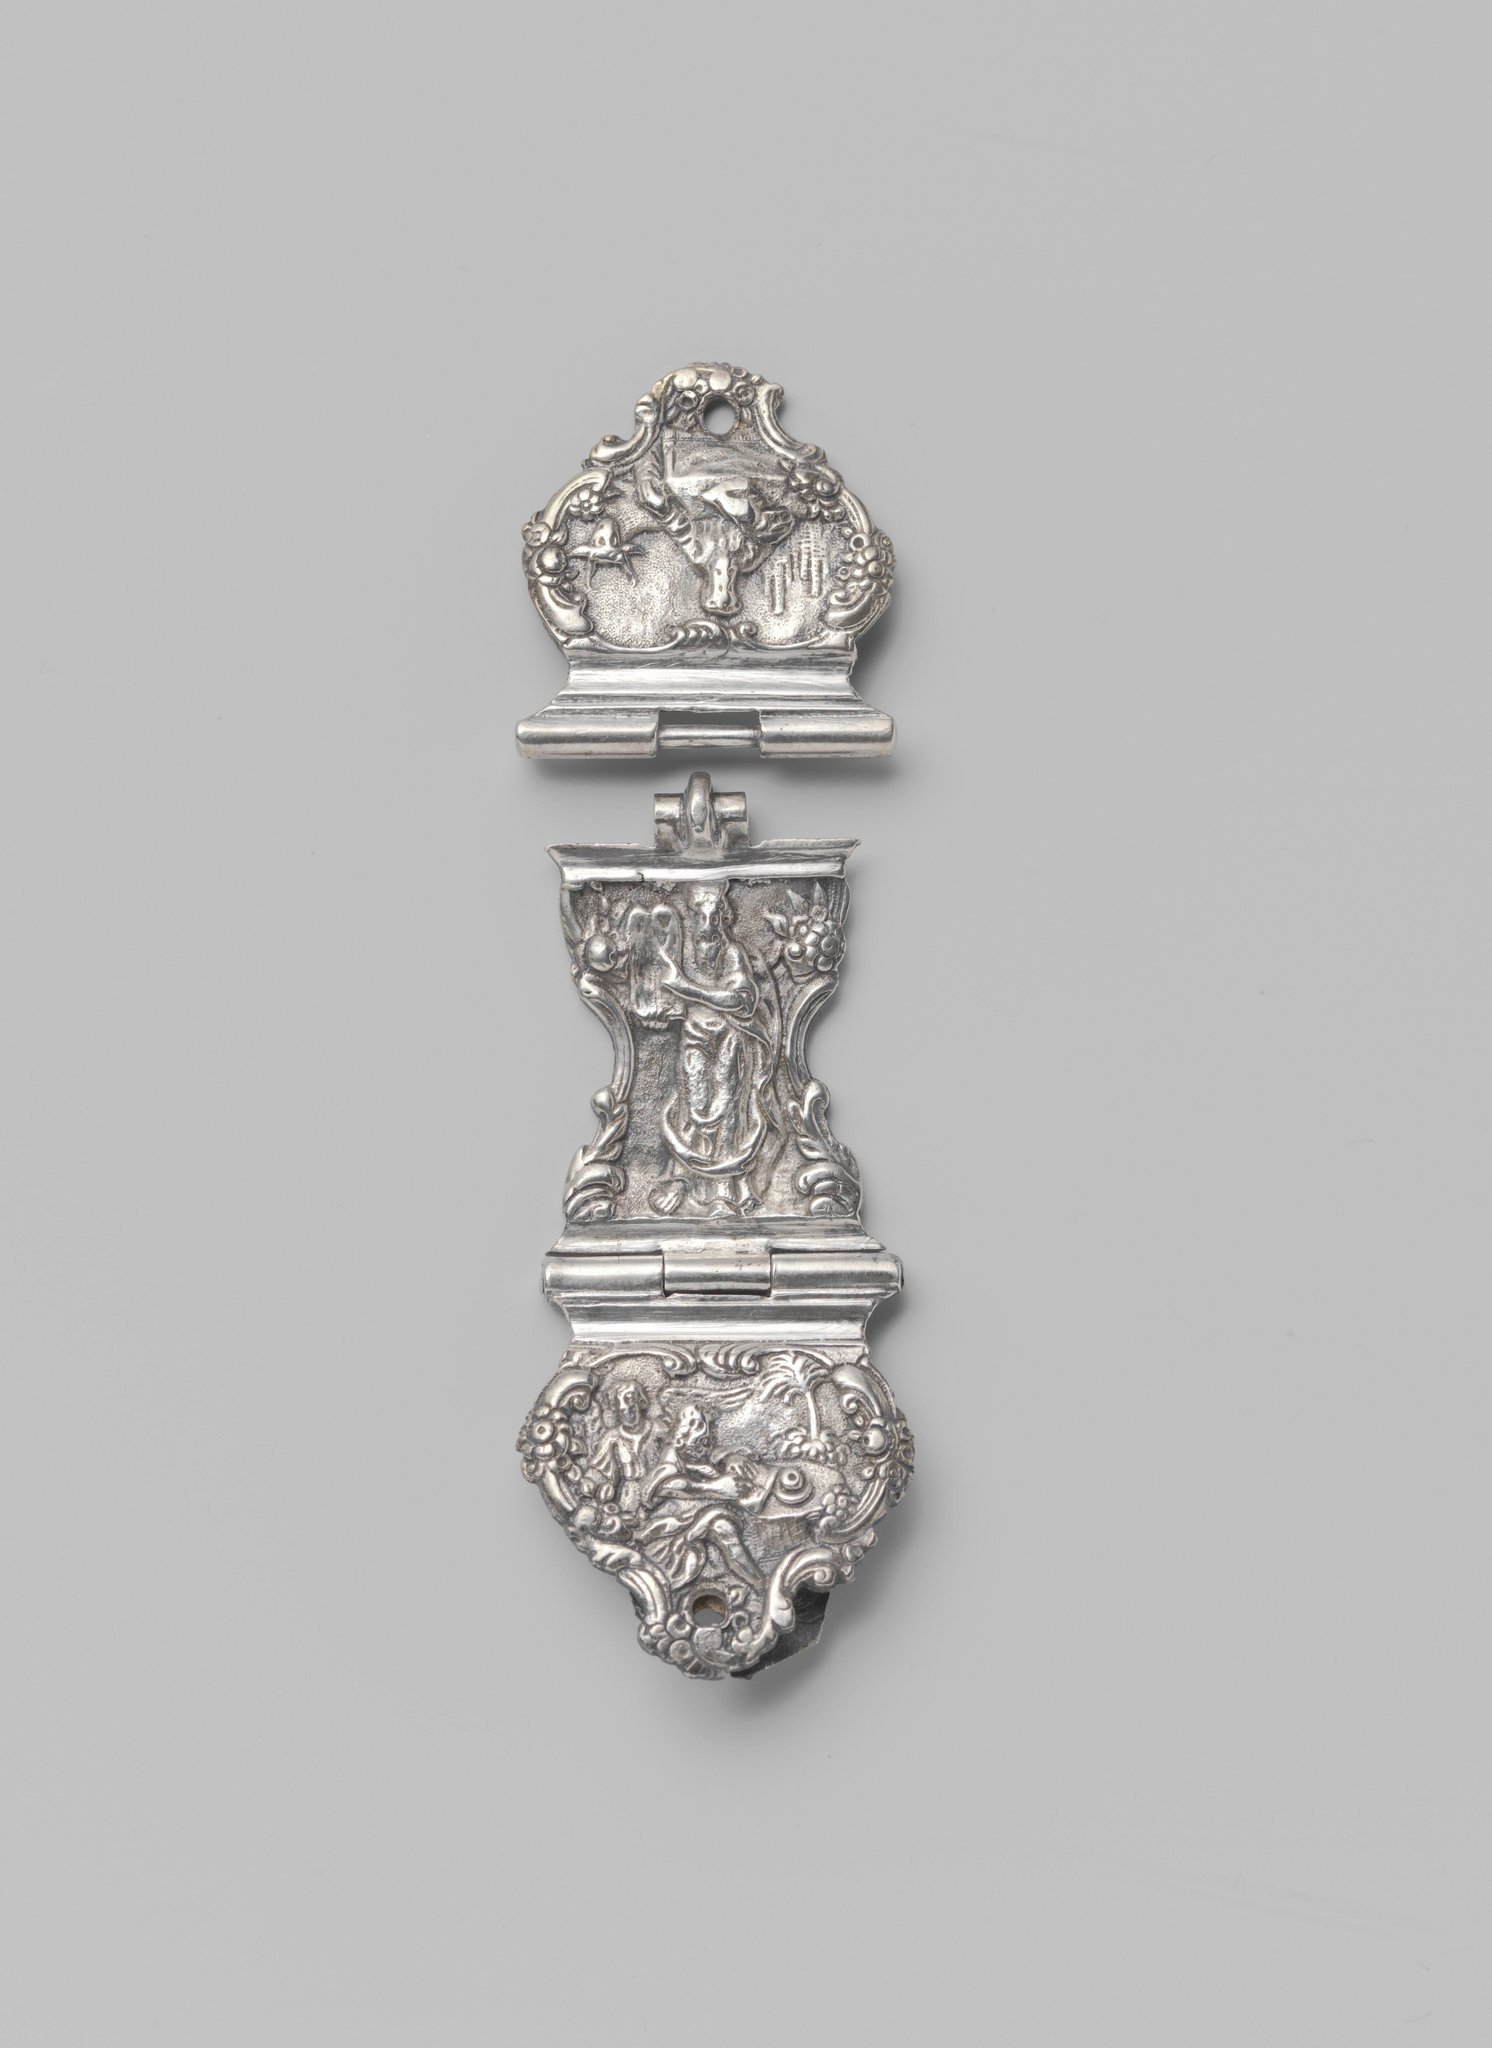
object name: boekslot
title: Boekslot met voorstelling van Aäron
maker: Anonymous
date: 1685-1700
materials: silver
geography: hoorn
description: Kerkboekslot van zilver, met voorstelling van Aäron. In de hoeken twee evangelisten. Gemerkt: ADVDL.